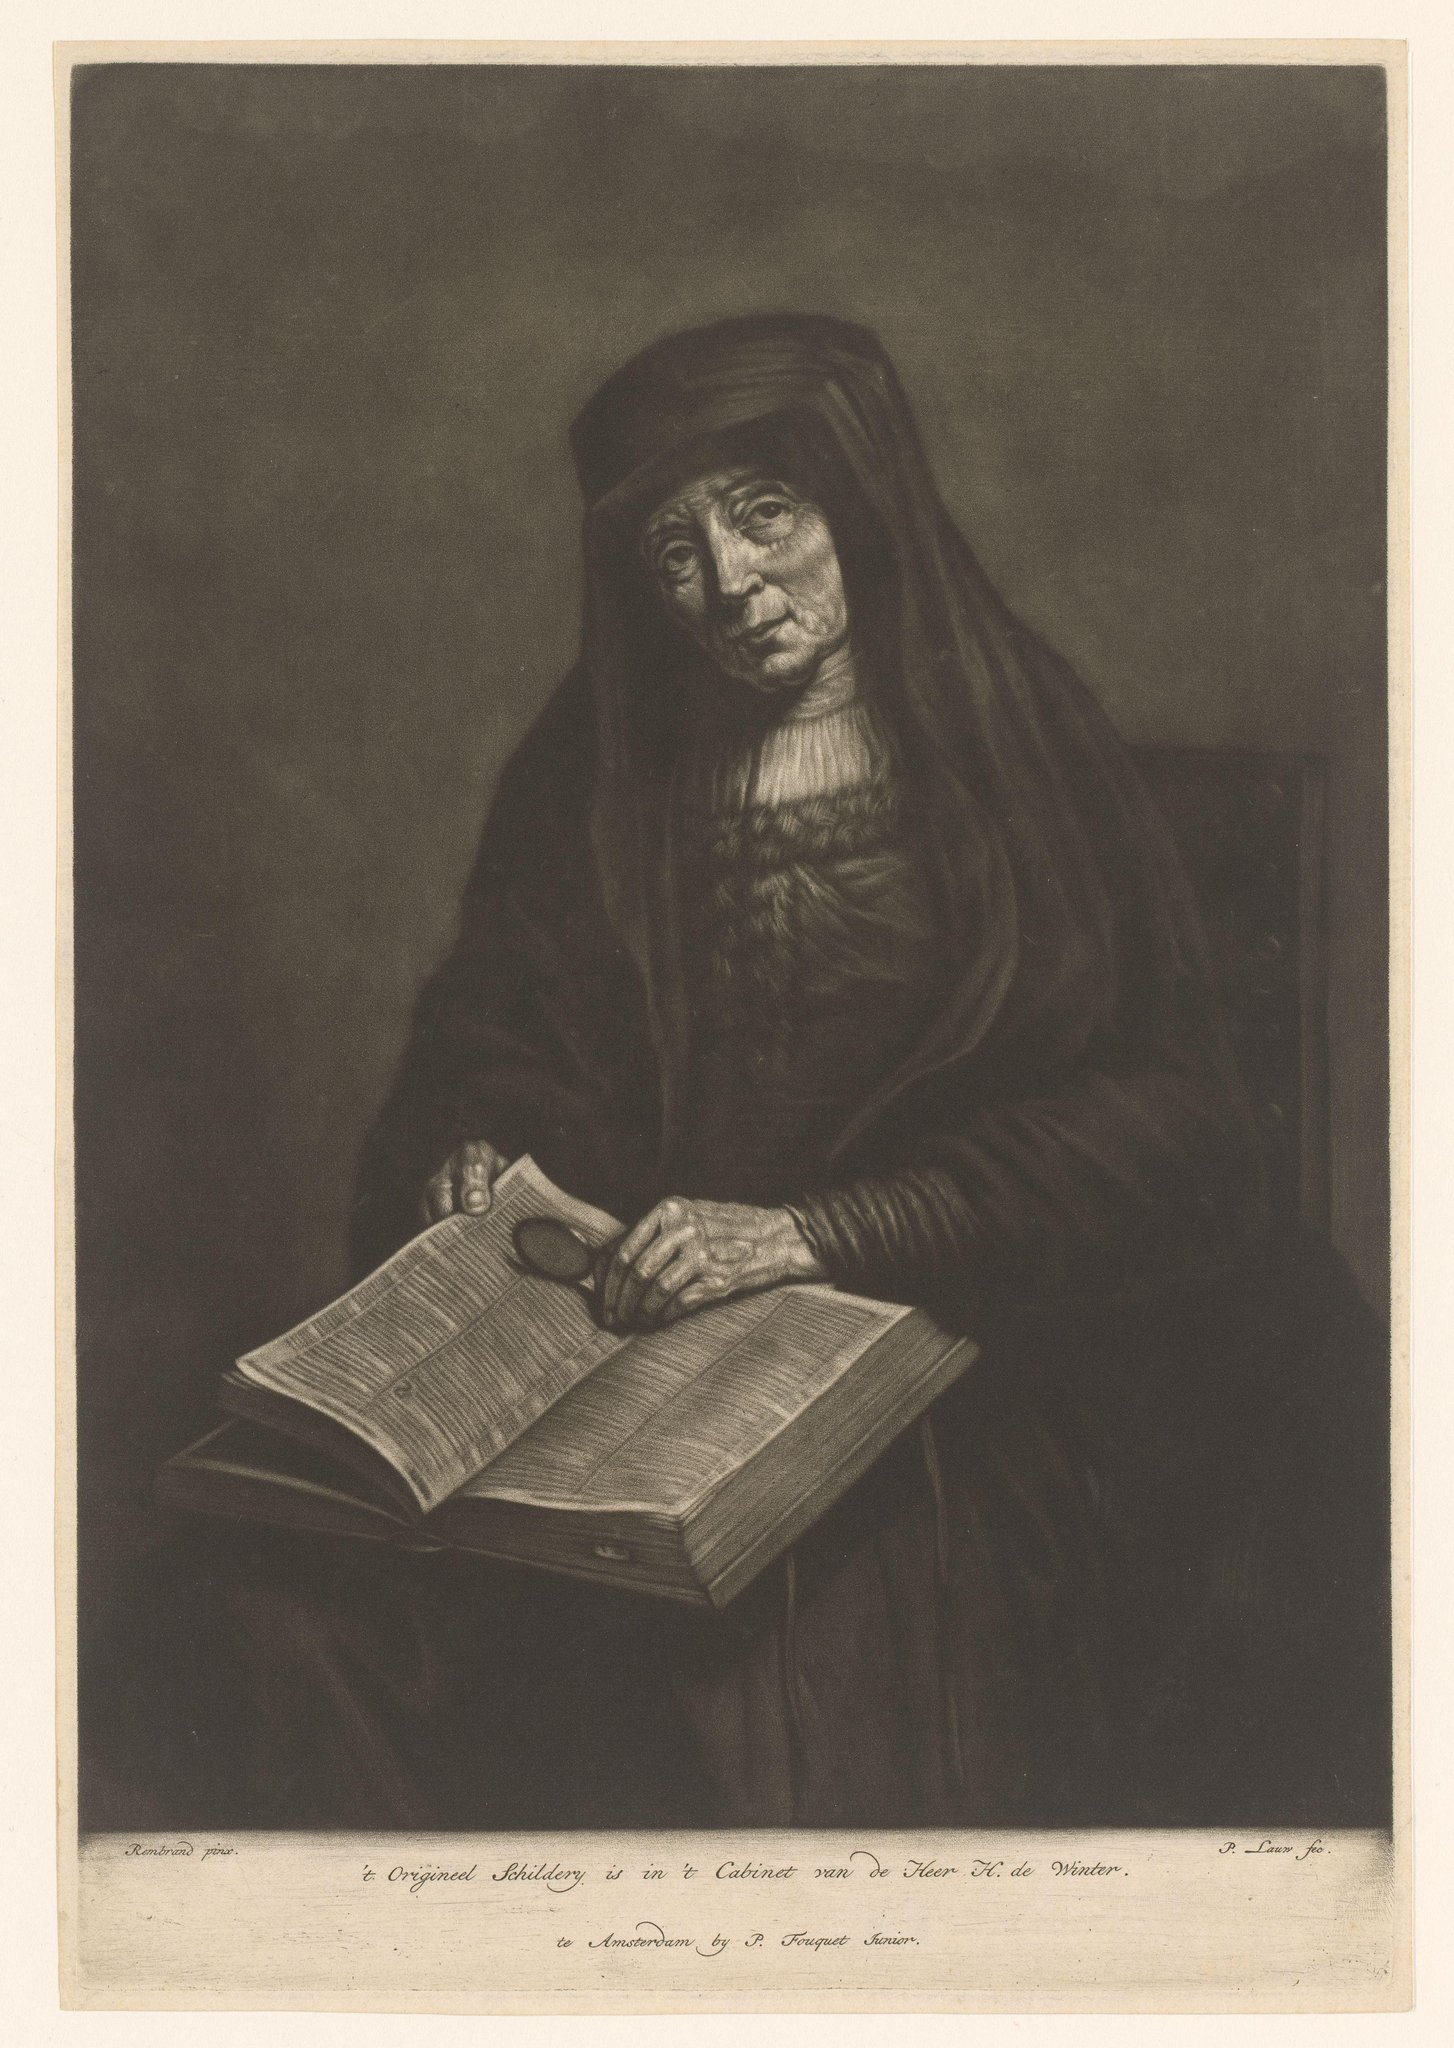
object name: print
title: Oude vrouw met bijbel op de schoot, mogelijk de moeder van Rembrandt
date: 1739-1800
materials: paper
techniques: mezzotint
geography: amsterdam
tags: old woman, reading the bible or other religious books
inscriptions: watermark, collector's mark: Lugt 533b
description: Oude vrouw met bijbel op de schoot, een knijpbril in de hand.